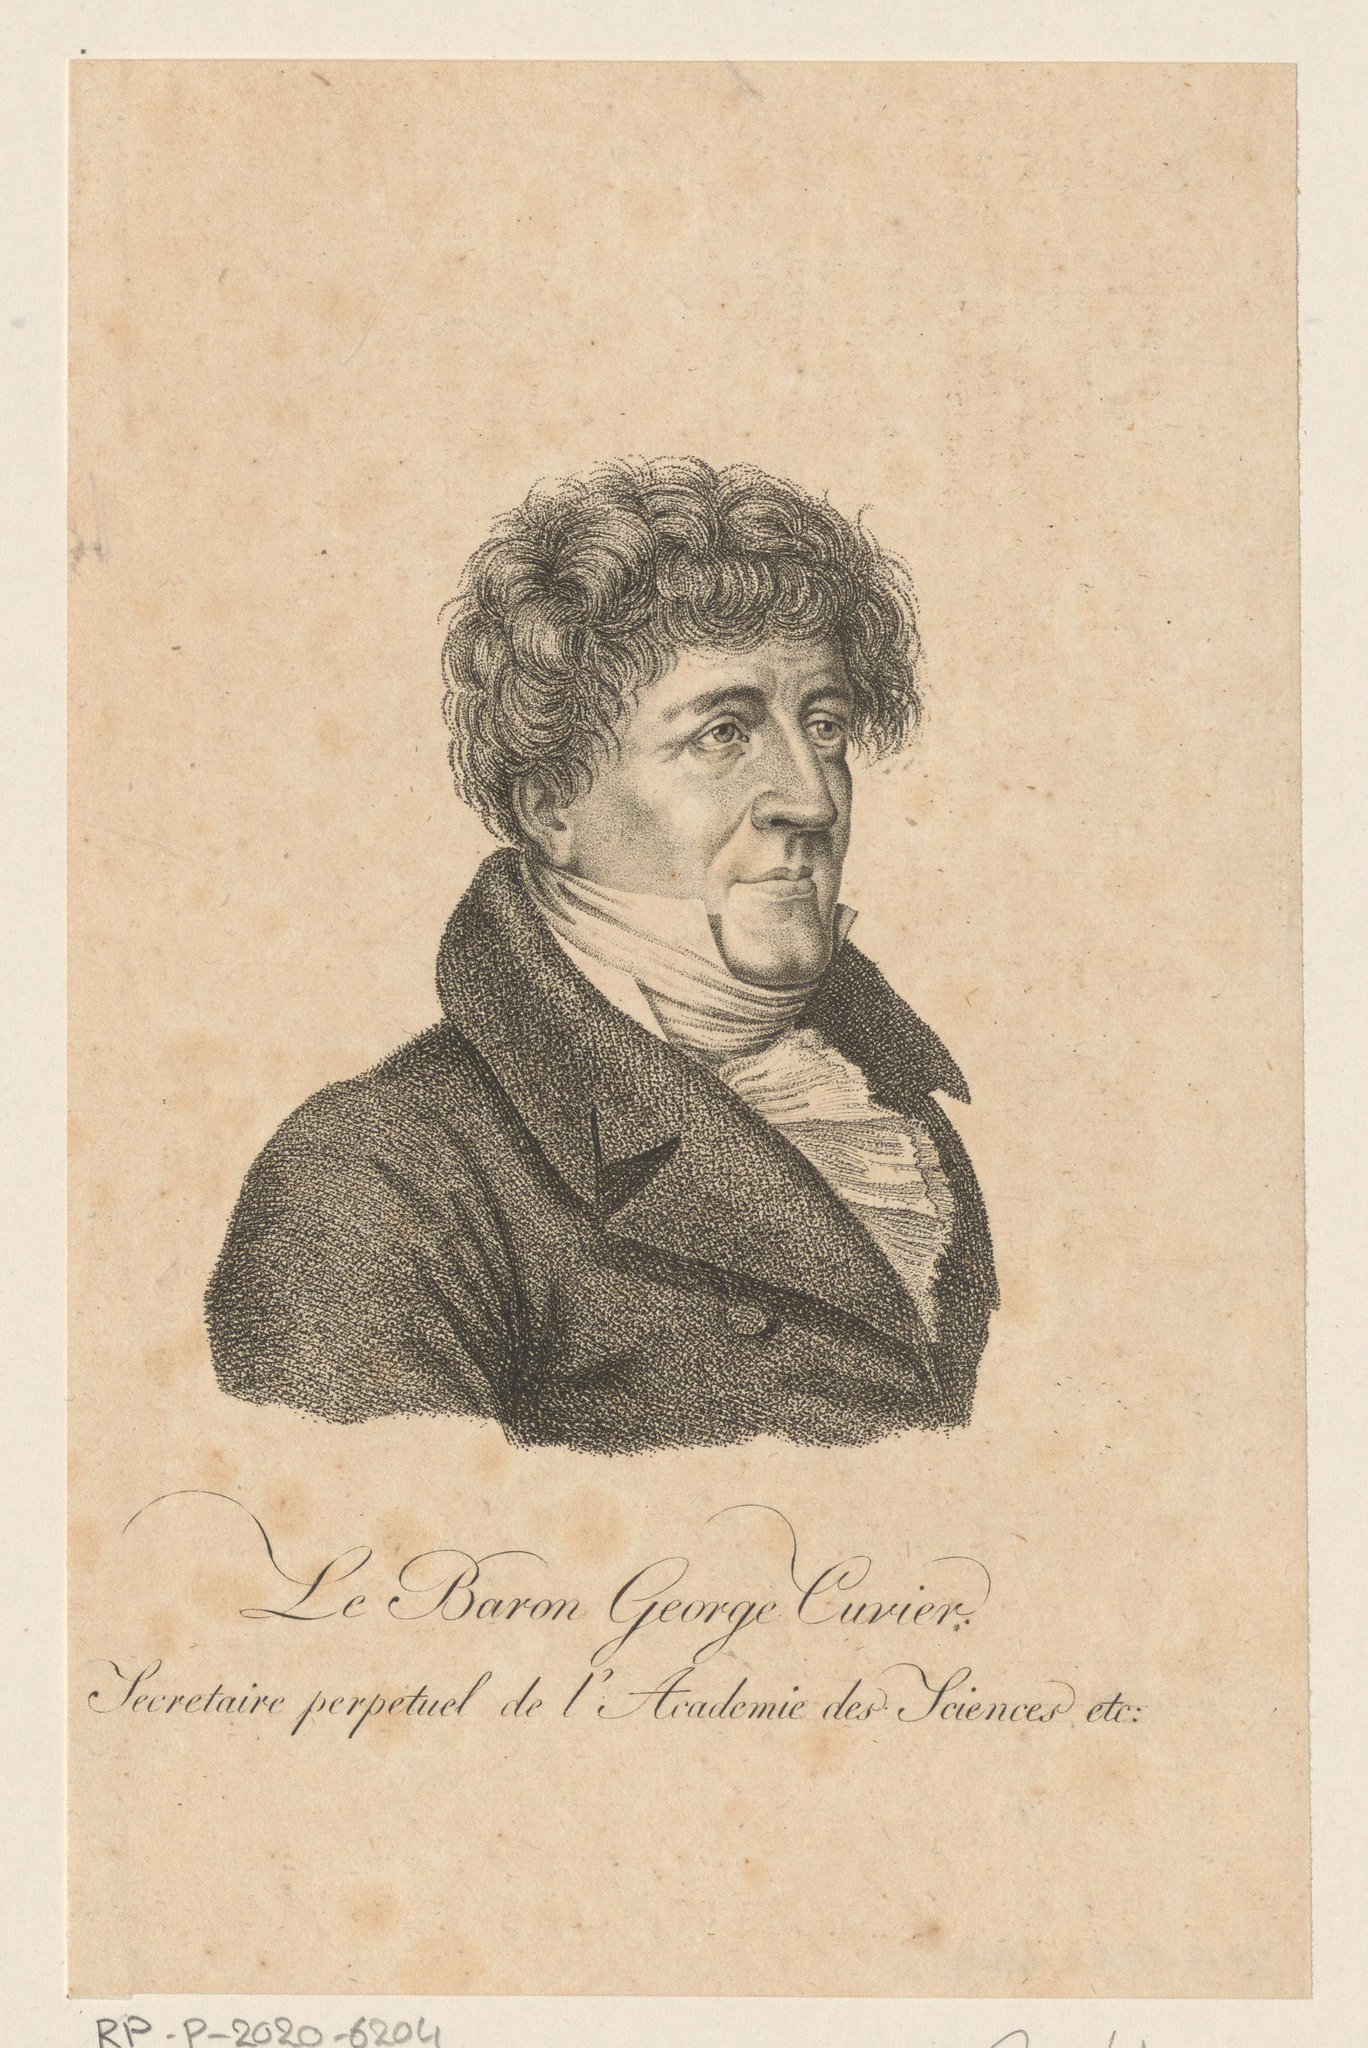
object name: print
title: Portret van Georges Cuvier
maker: Anonymous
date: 1800-1849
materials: paper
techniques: lithograph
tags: paris, historical persons